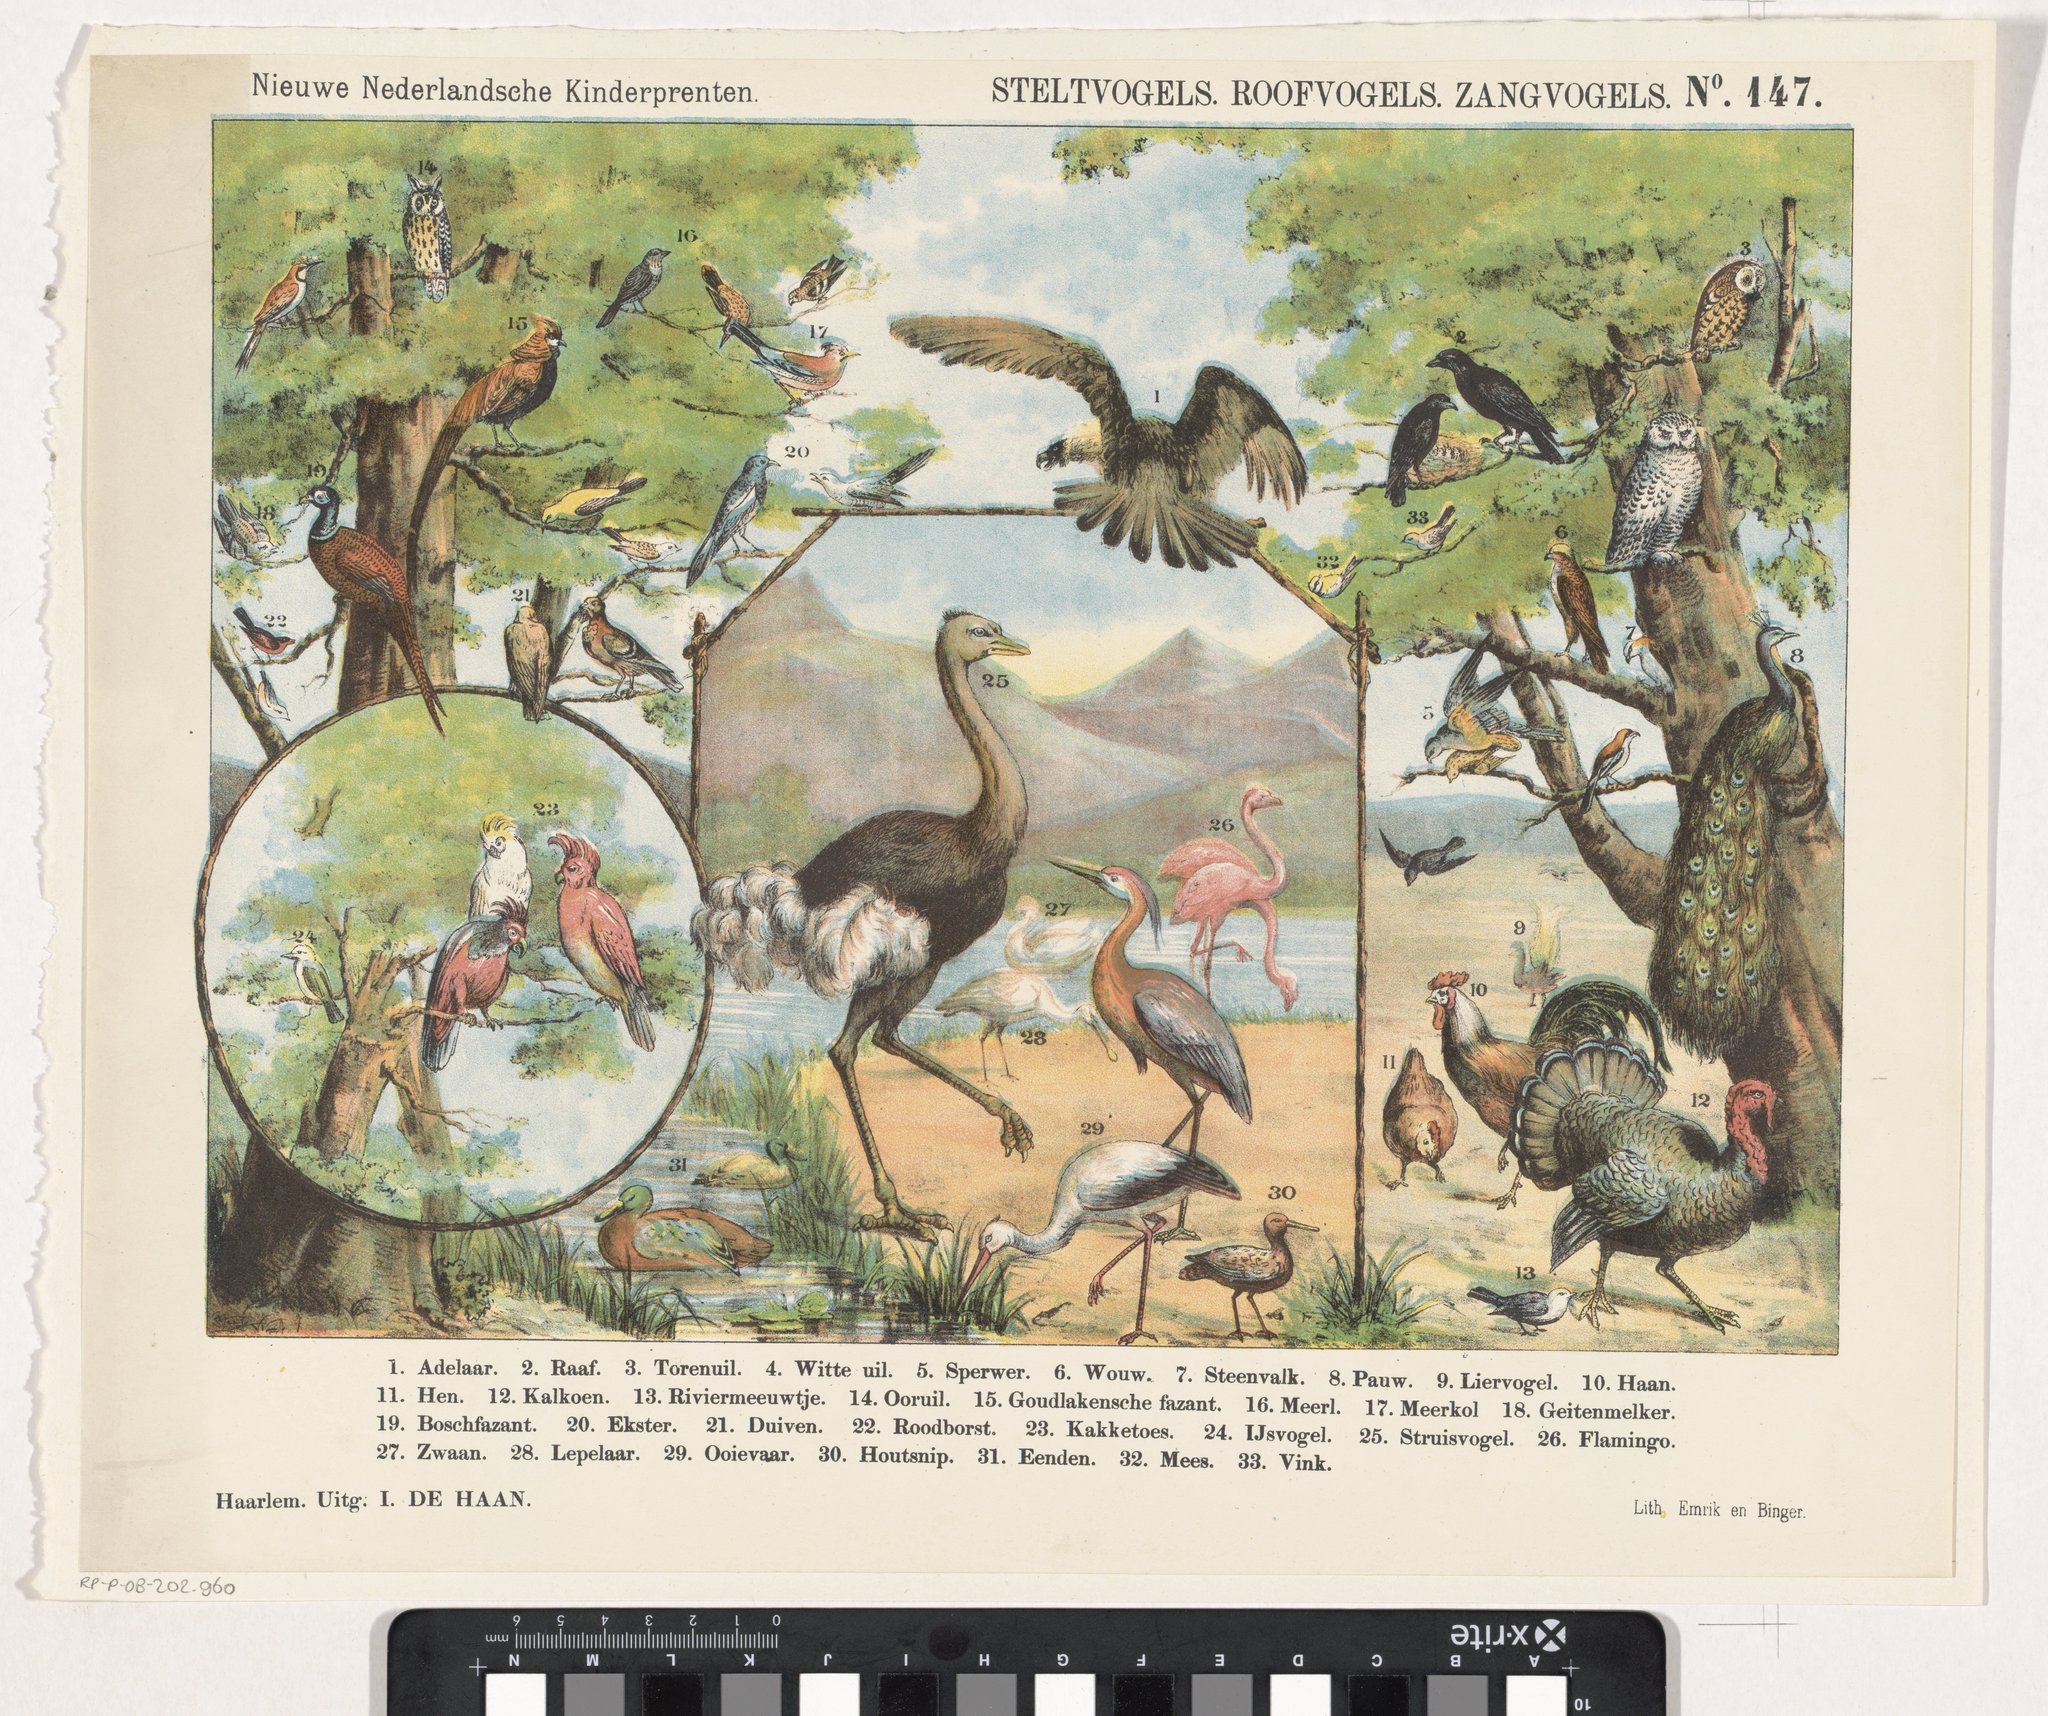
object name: print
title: Nieuwe Nederlandsche kinderprenten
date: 1875-1903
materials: paper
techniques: lithograph, letterpress printing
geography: haarlem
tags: birds, fowl (cock, hen, chicken, etc.)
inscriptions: collector's mark: Lugt 2760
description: Blad met 3 voorstellingen van in totaal 33 soorten vogels, zoals een adelaar, een struisvogel, flamingo's en een kalkoen. In de ondermarge een verklarende lijst met nummers. Genummerd rechtsboven: No. 147.